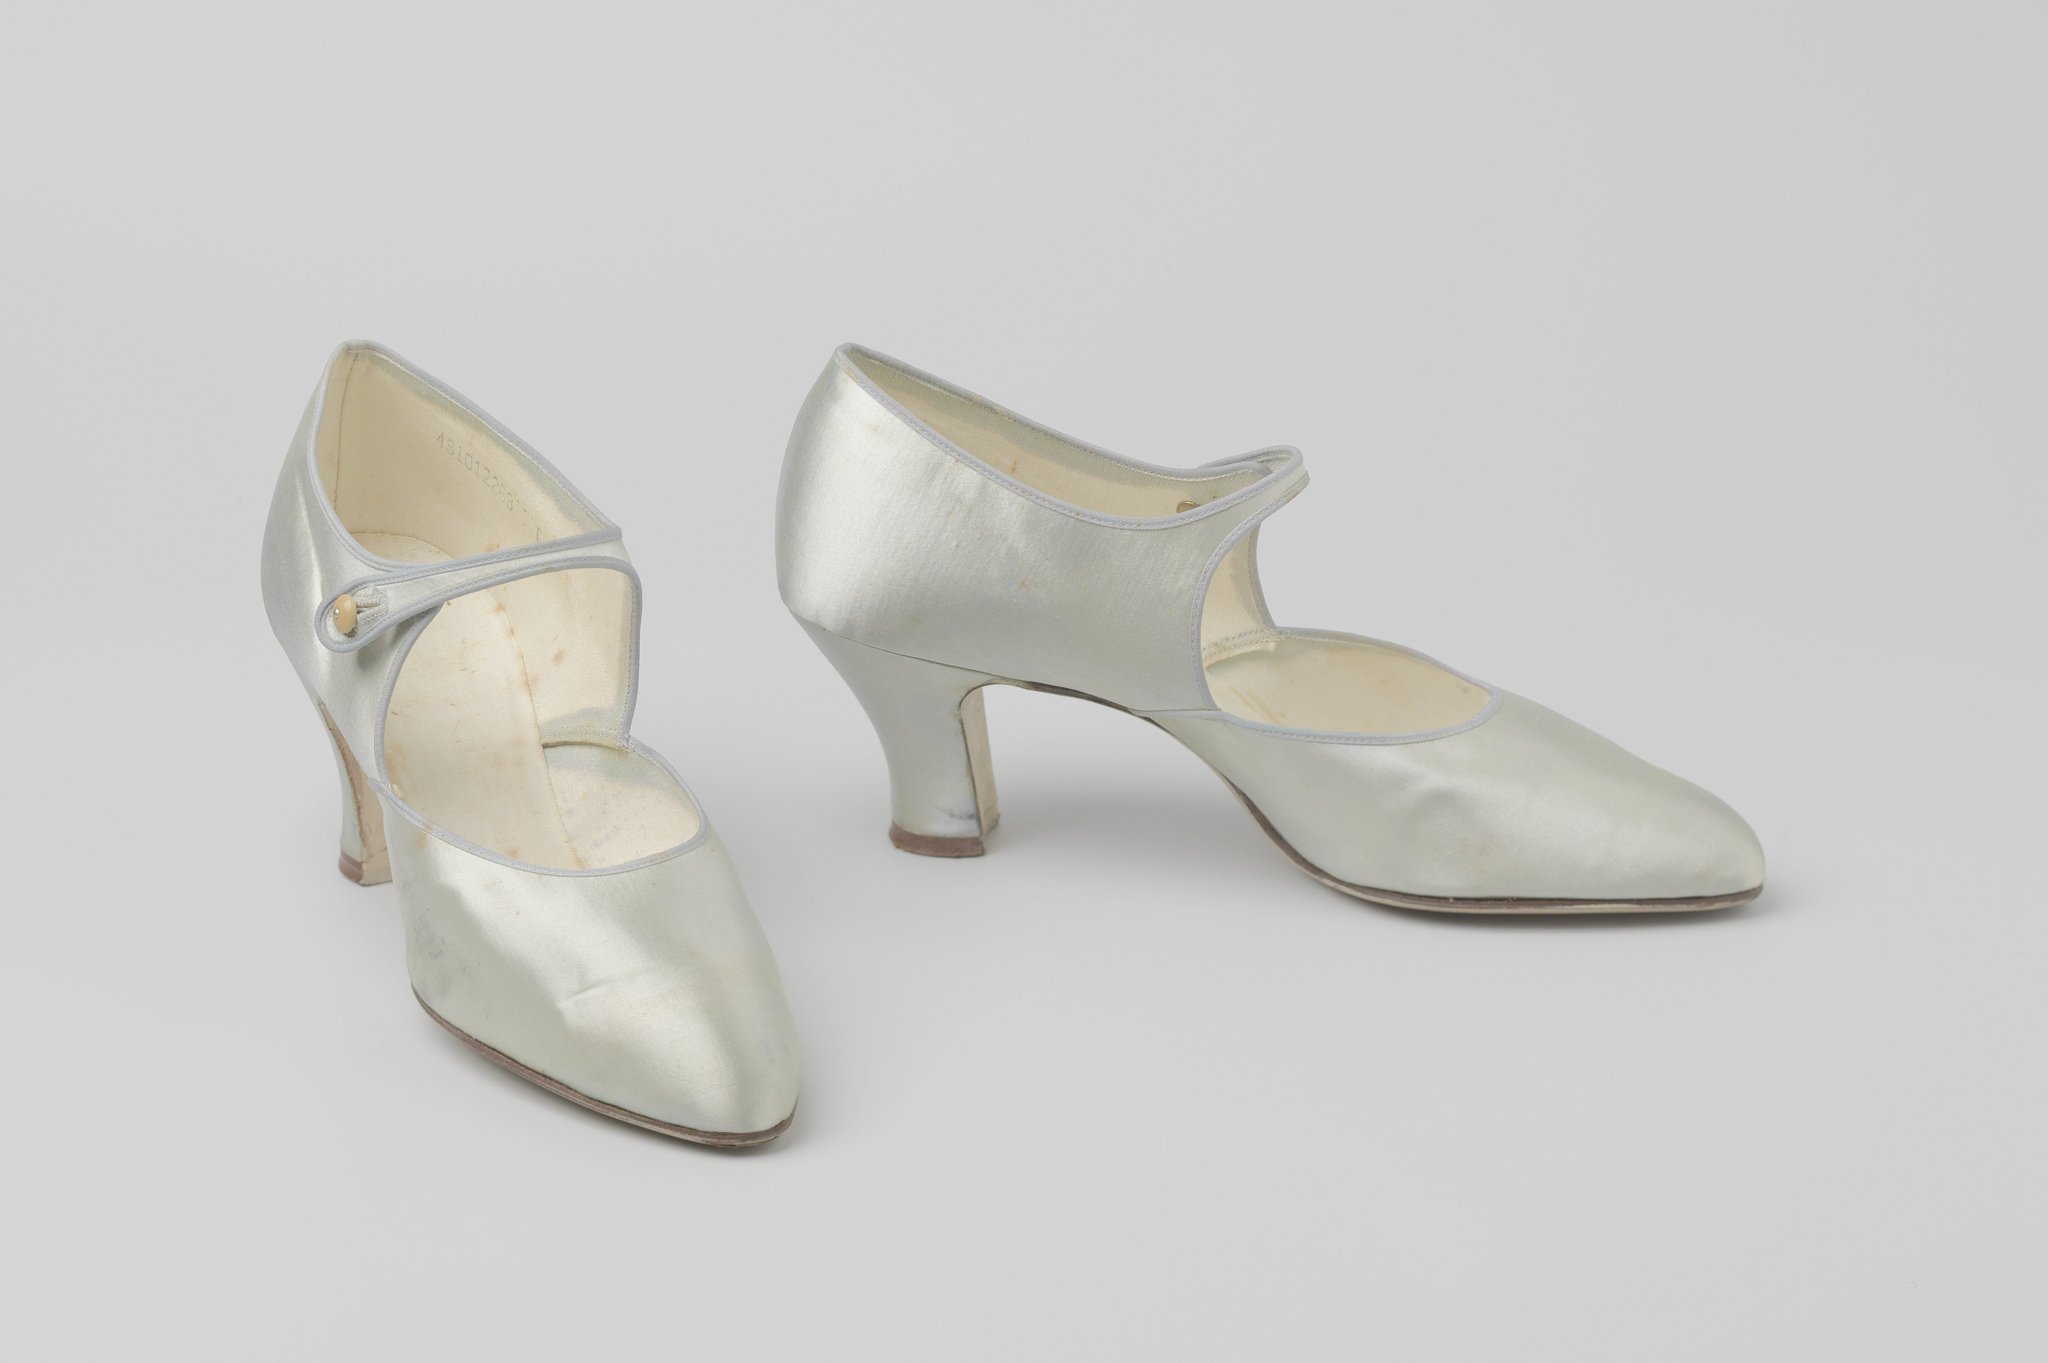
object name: womenswear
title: Avondschoen van lichtblauw satijn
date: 1928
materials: textile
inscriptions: factory mark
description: Avondschoen met riemen van lichtblauw satijn. Puntneus. Voorblad los van zijbladen. Zware, middelhoge hak. Beige knoopjes aan een metalen oogje. Adres, op de buitenzool een afgesleten blindstempel: boven een schoentje en profil en onder B a t a (?) fl 2,90.